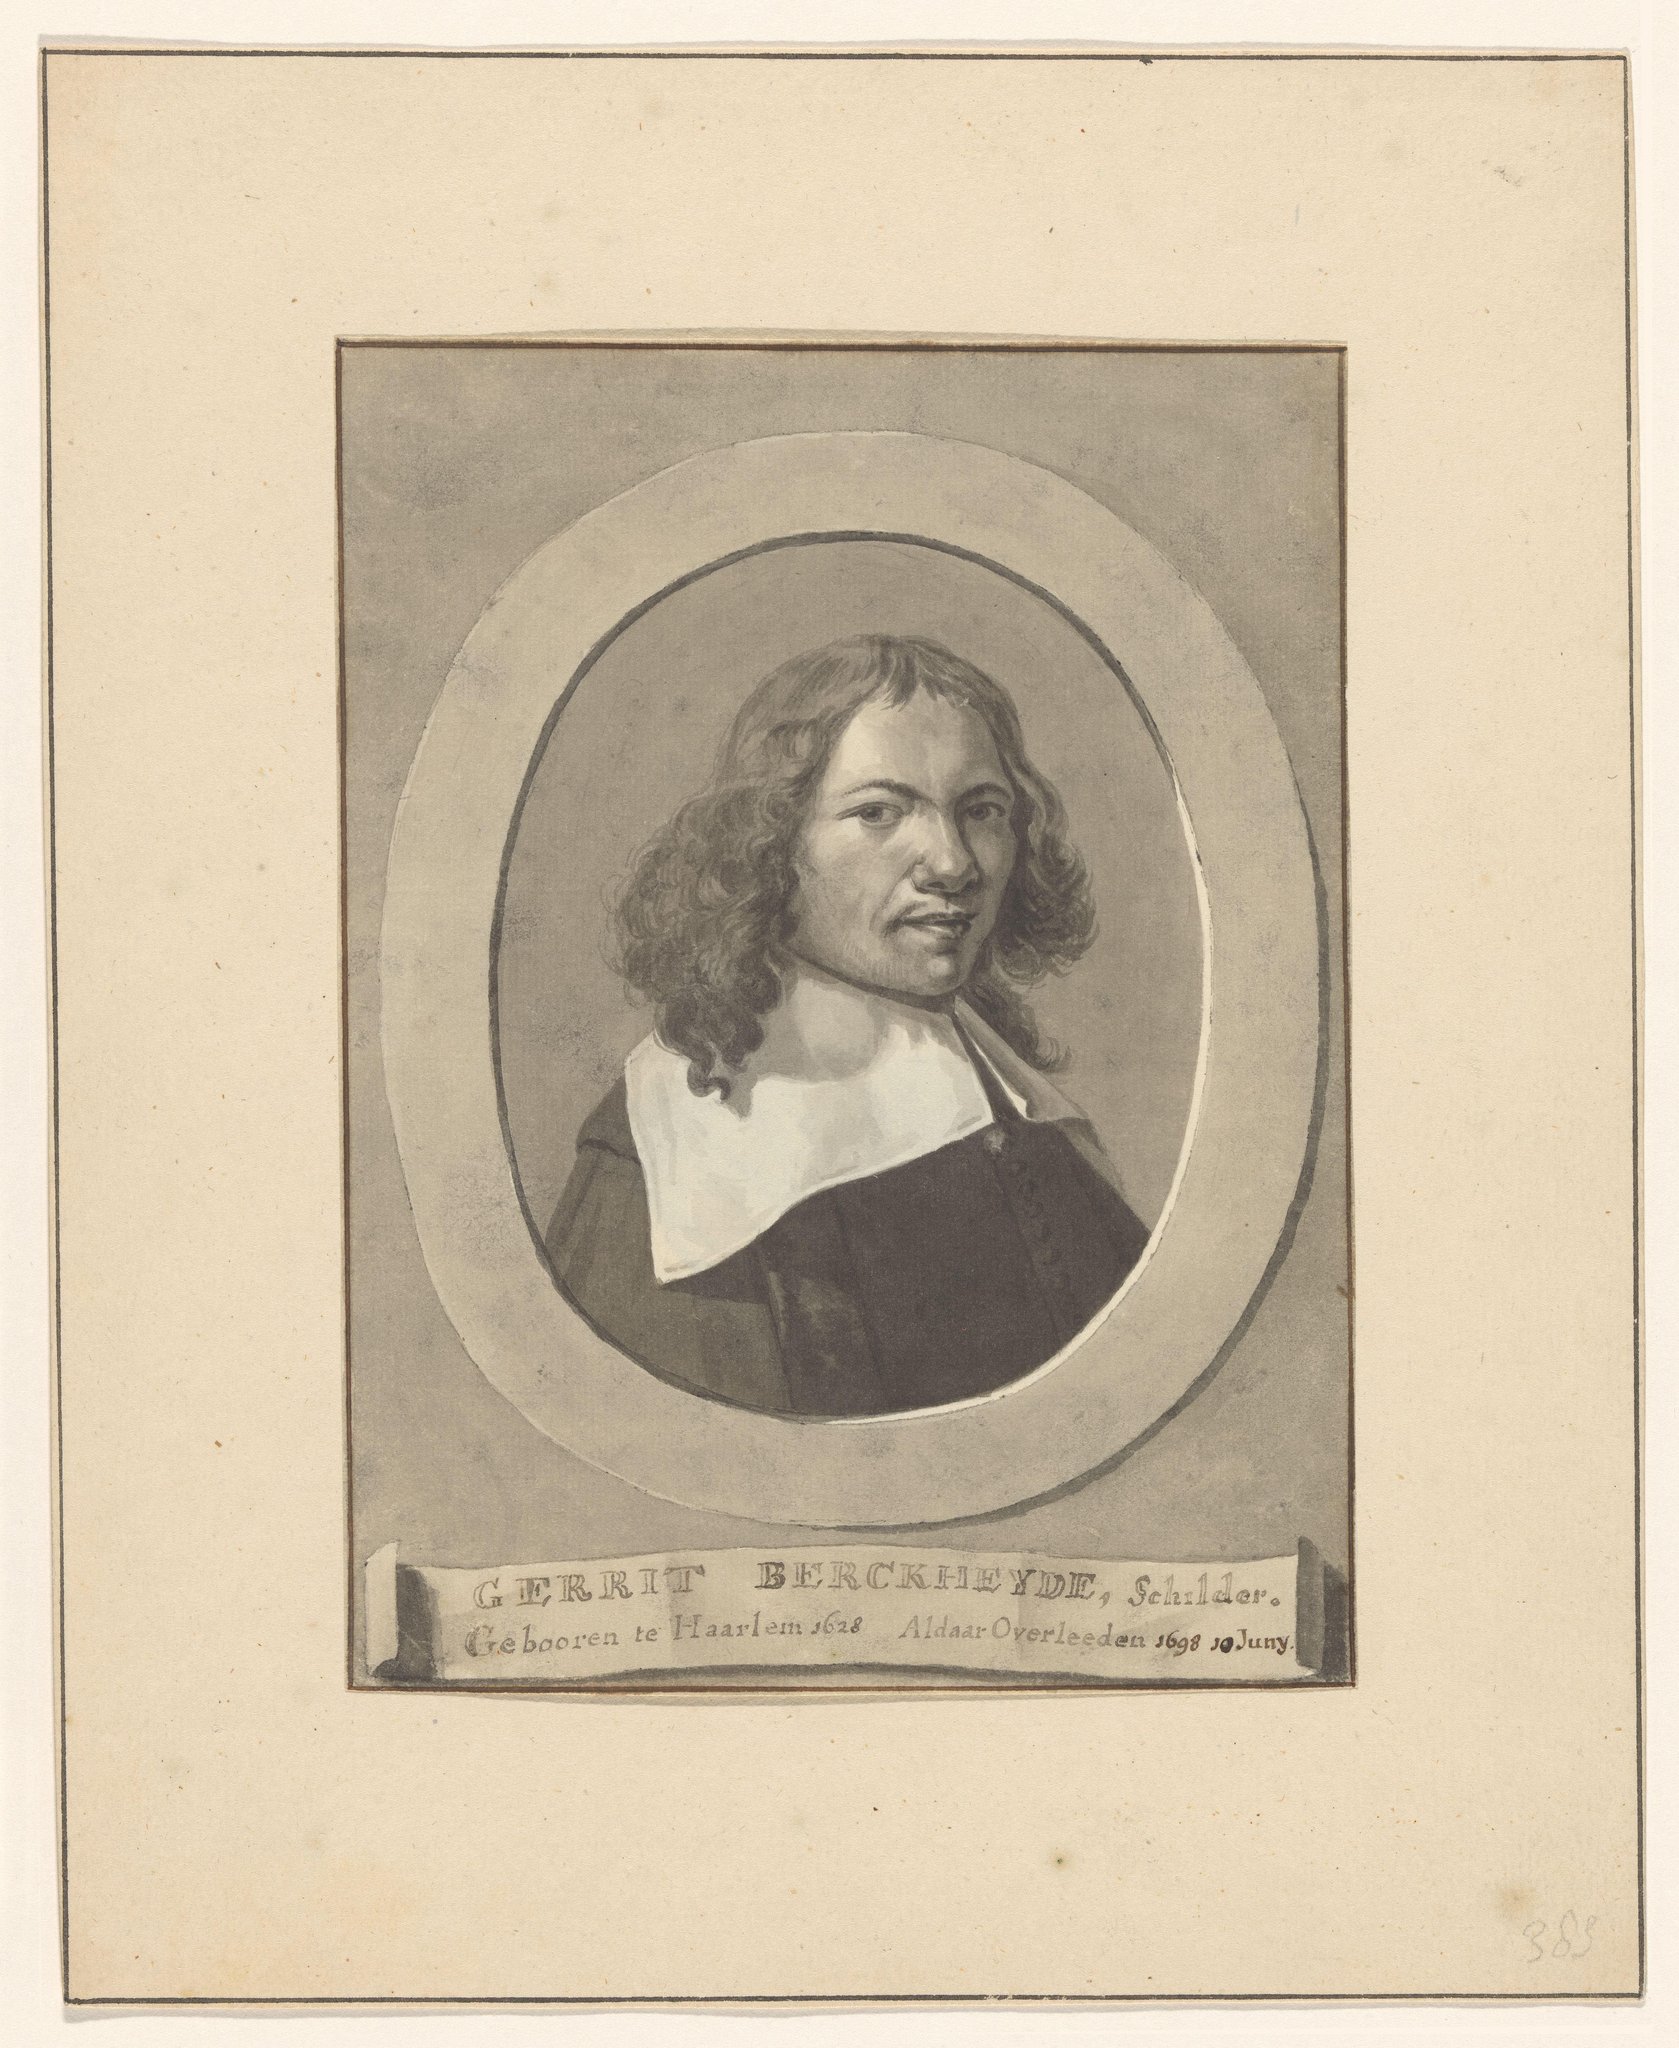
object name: drawing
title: Portret van de kunstschilder Gerrit Berckheyde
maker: Anonymous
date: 1725-1775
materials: pencil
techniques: brush, pen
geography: netherlands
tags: haarlem, painter, draughtsman, gerrit berckheyde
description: Naar een miniatuur op koper door Job Berckheyde uit ongeveer 1655, thans in het Frans Halsmuseum, Haarlem.